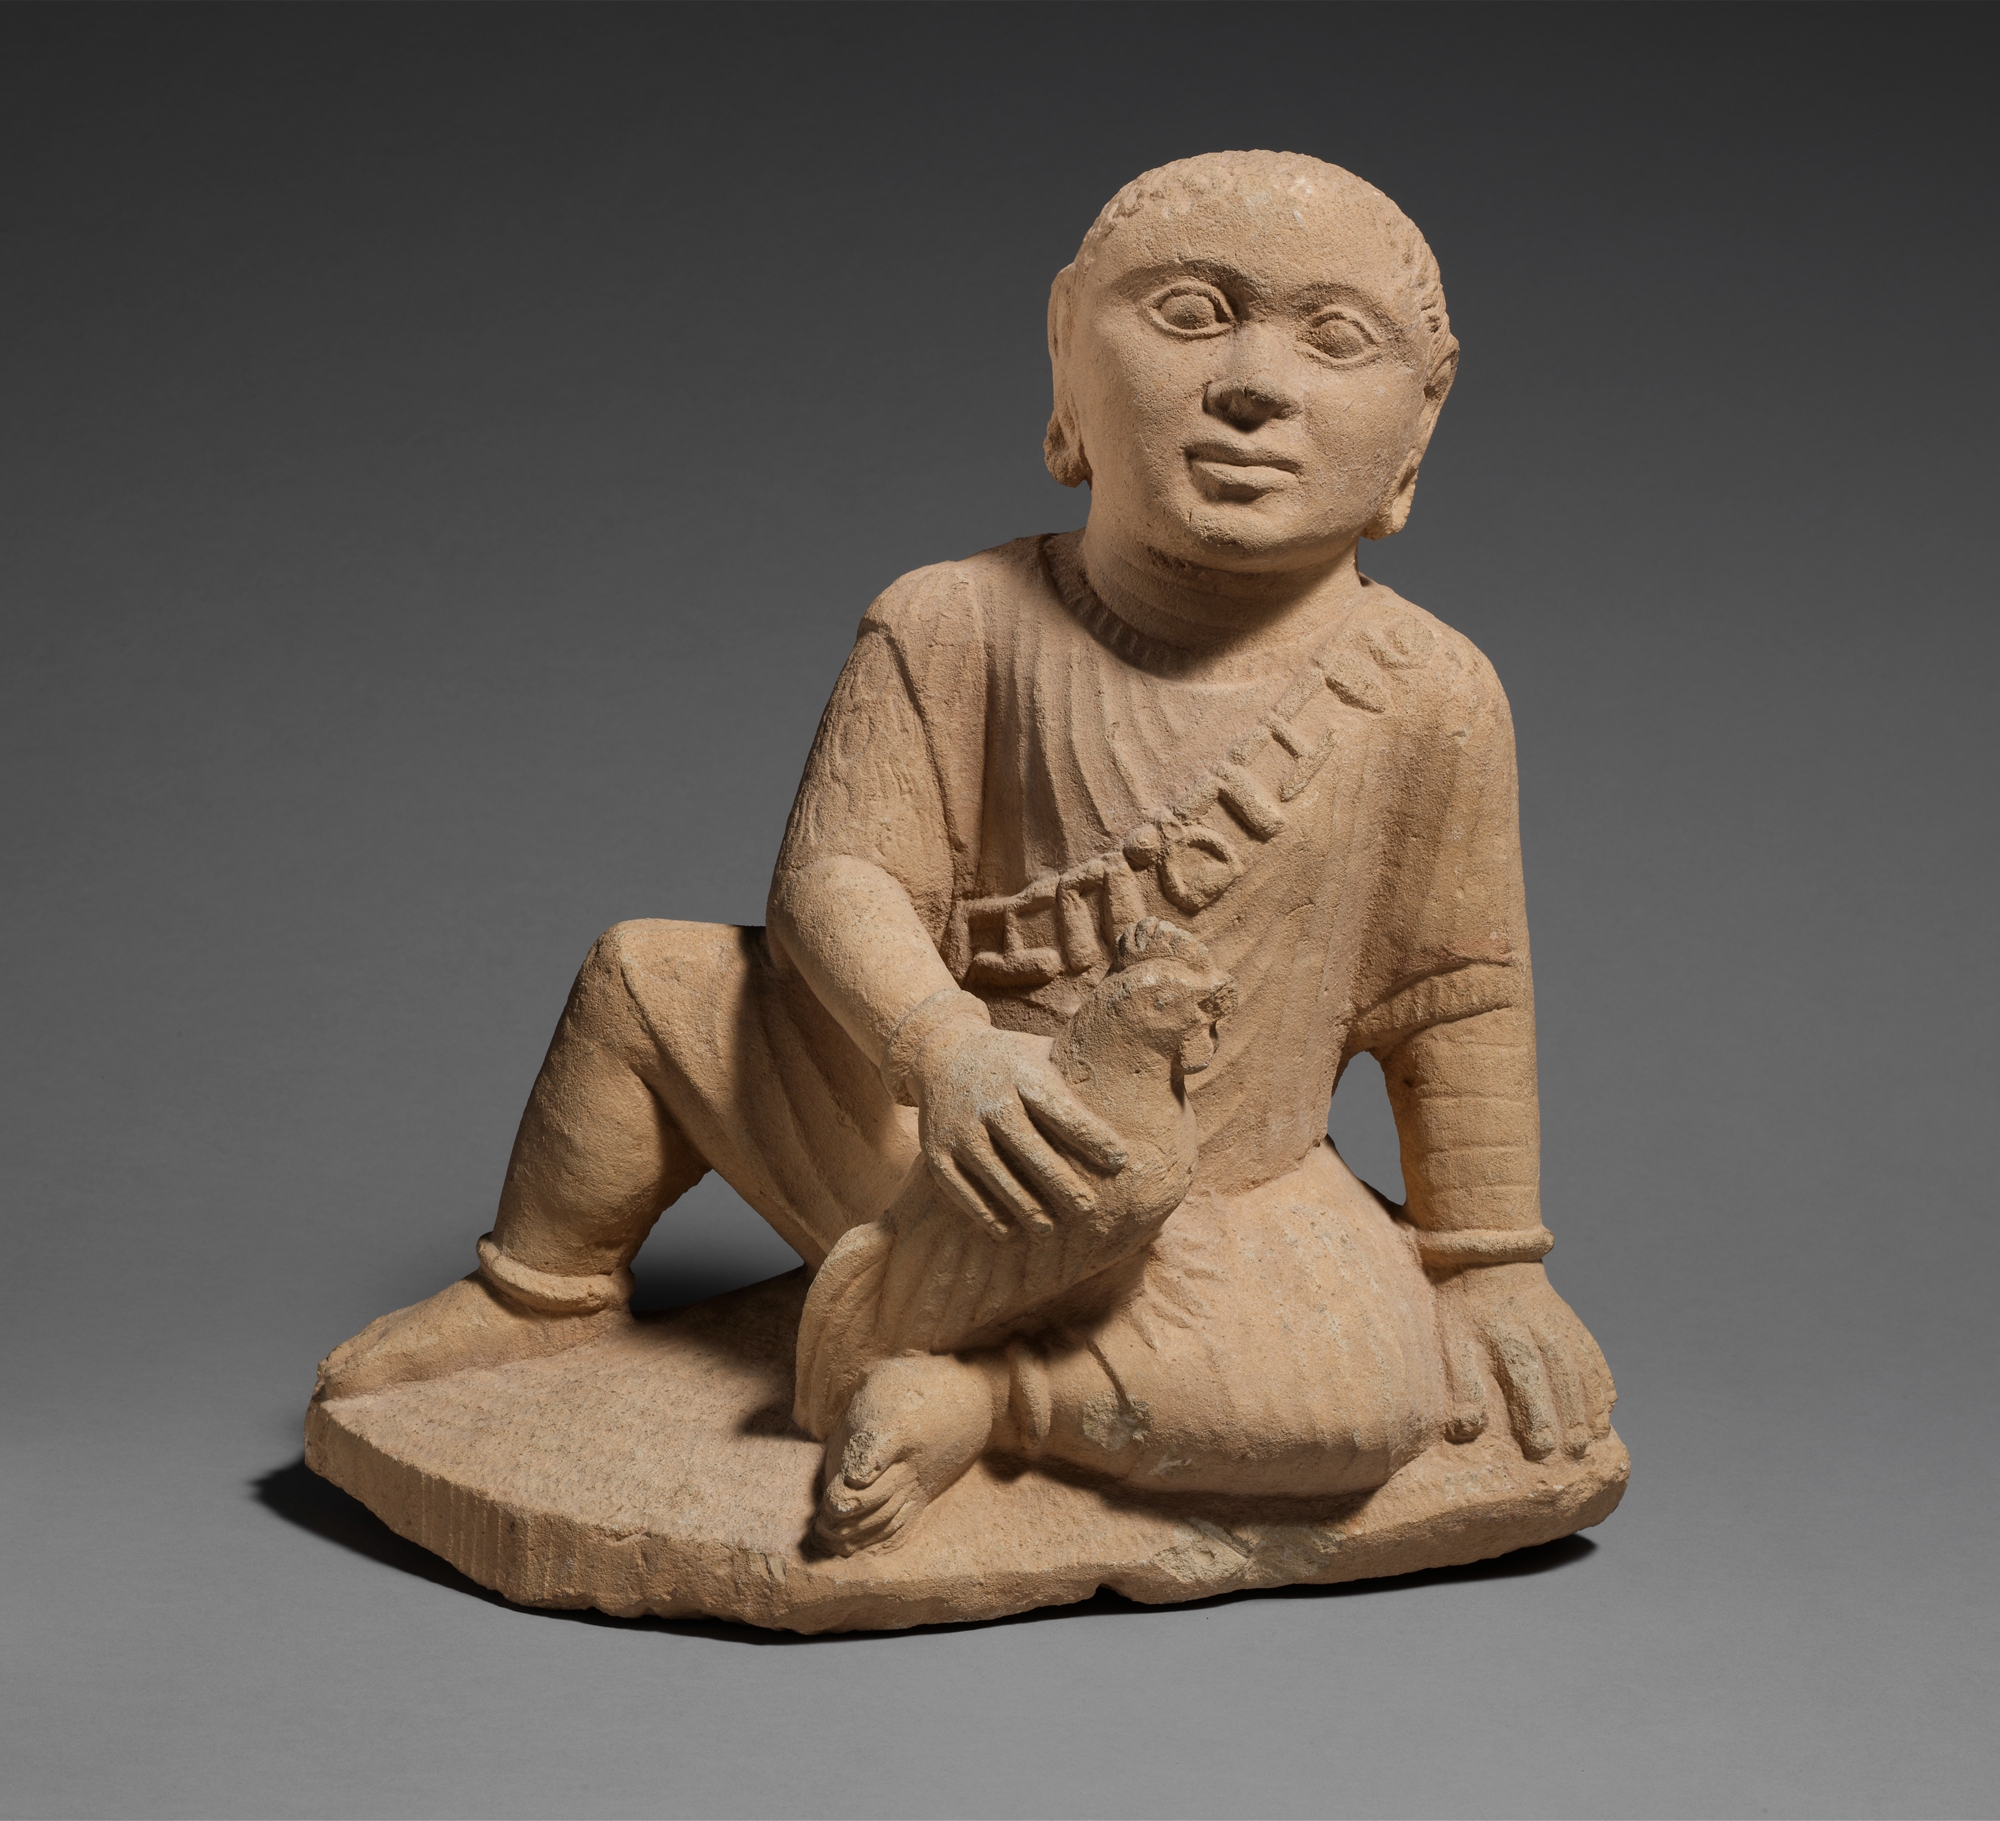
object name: statuette of a temple boy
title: Limestone temple boy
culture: cypriot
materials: limestone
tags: birds,boys